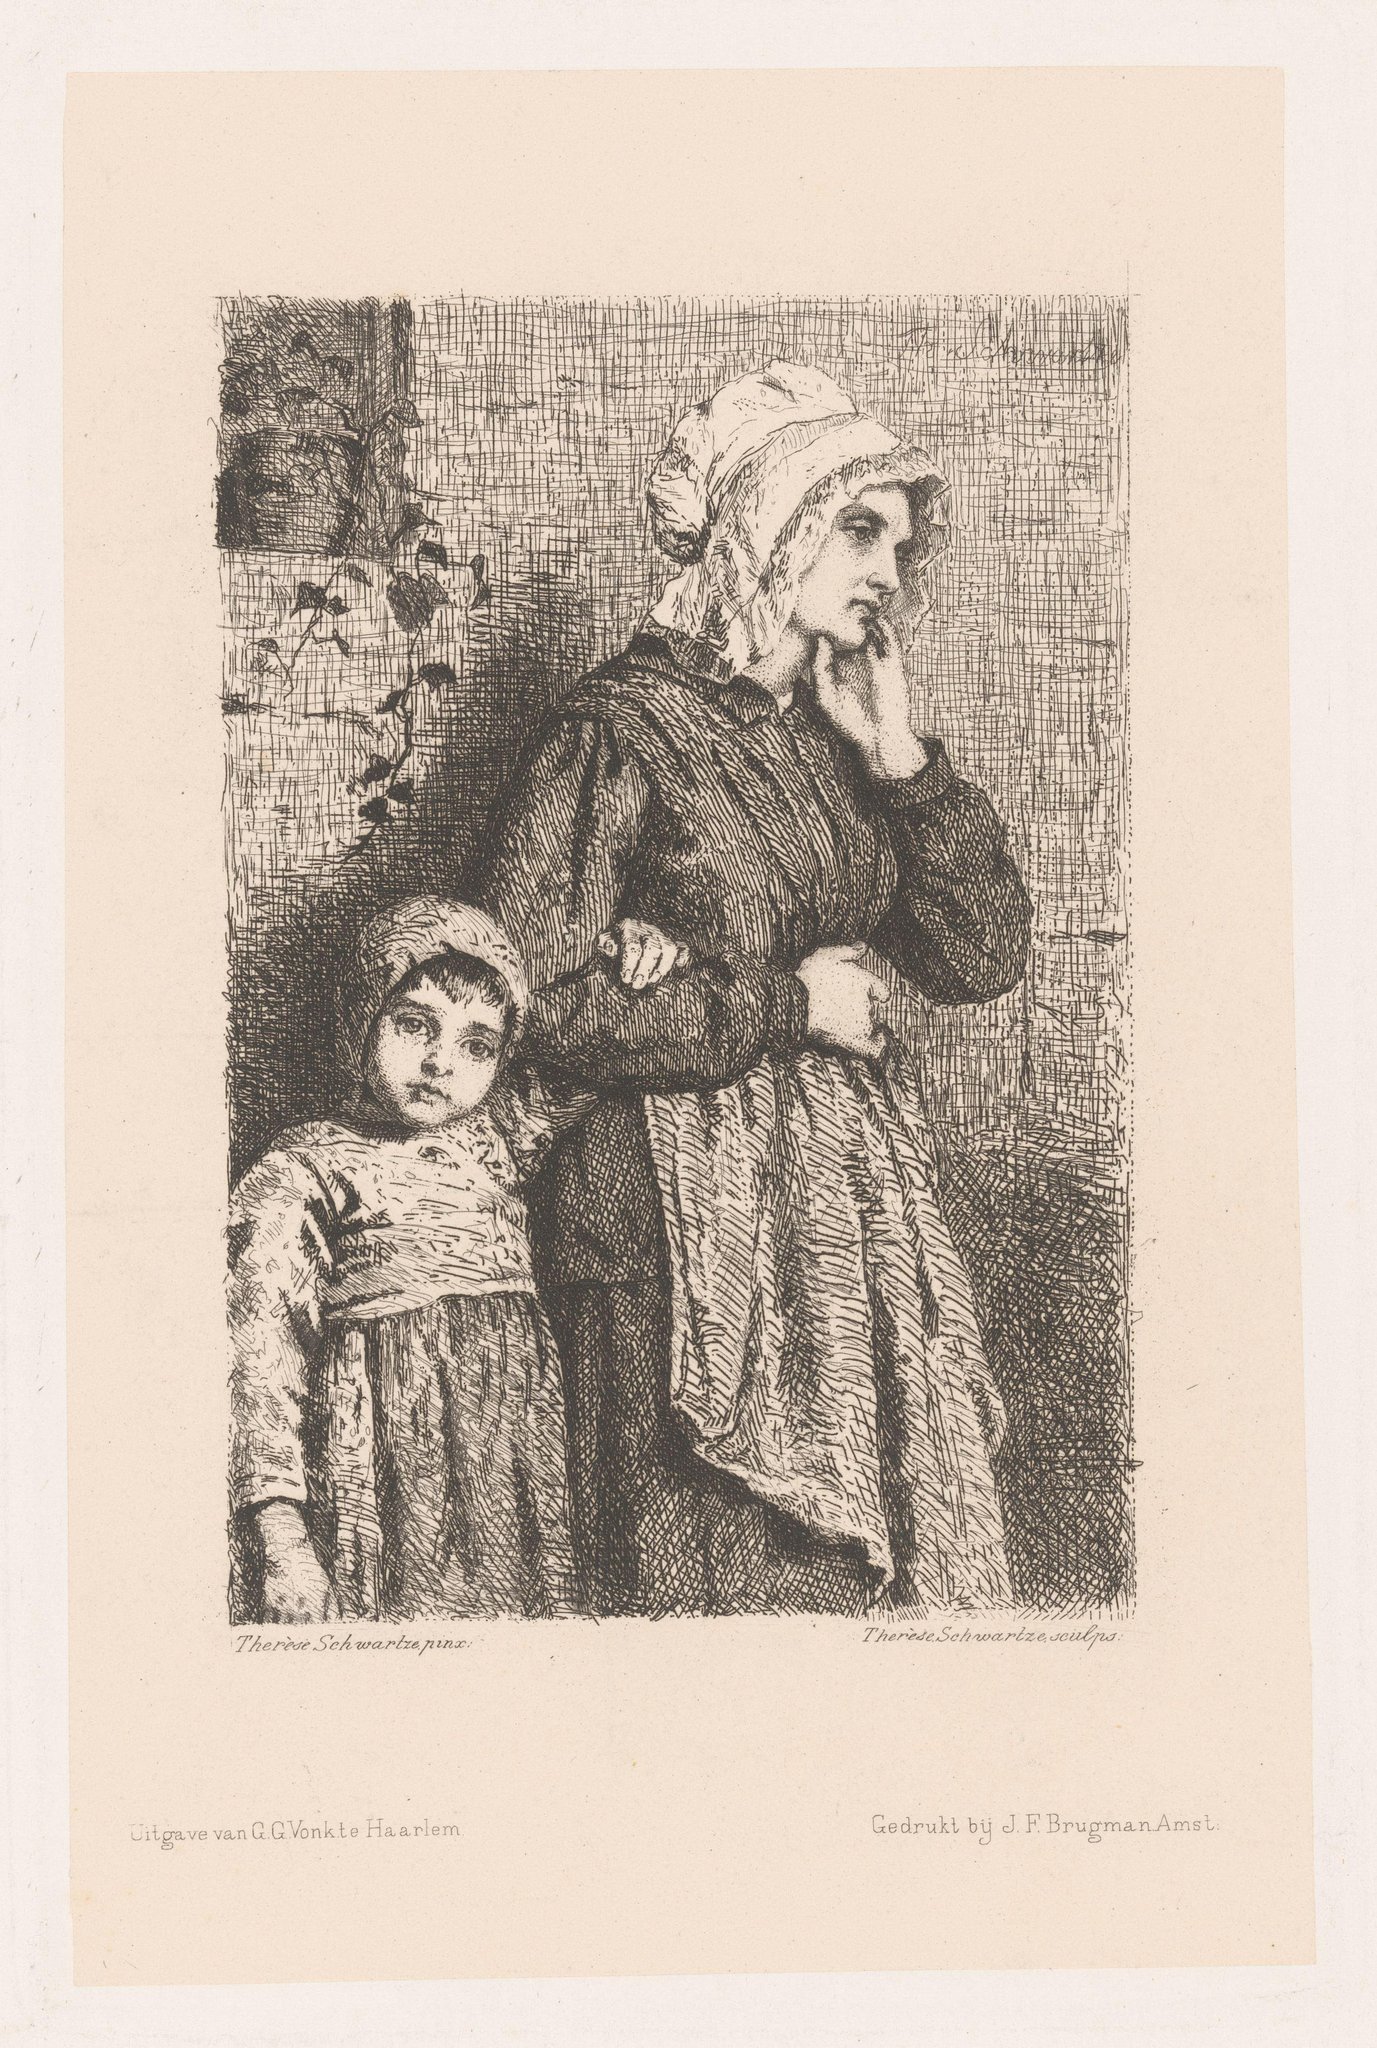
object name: print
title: Vrouw met kind aan de arm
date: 1861-1918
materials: paper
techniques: etching, letterpress printing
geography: amsterdam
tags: mother and child(ren), woman and child(ren) (family group)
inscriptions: collector's mark: Lugt 2760, collector's mark: Lugt 2228